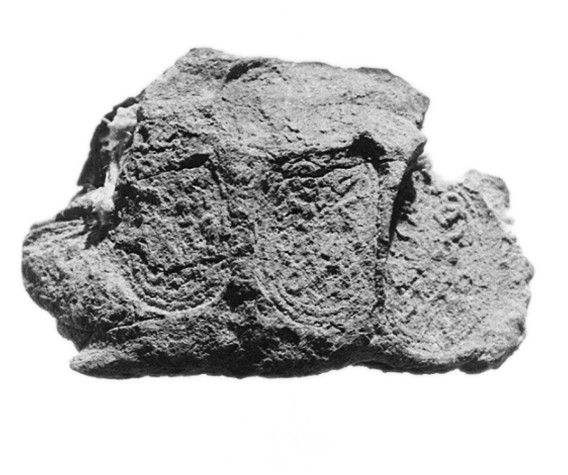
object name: sealing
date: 1981-1640 BCE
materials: clay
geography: egypt